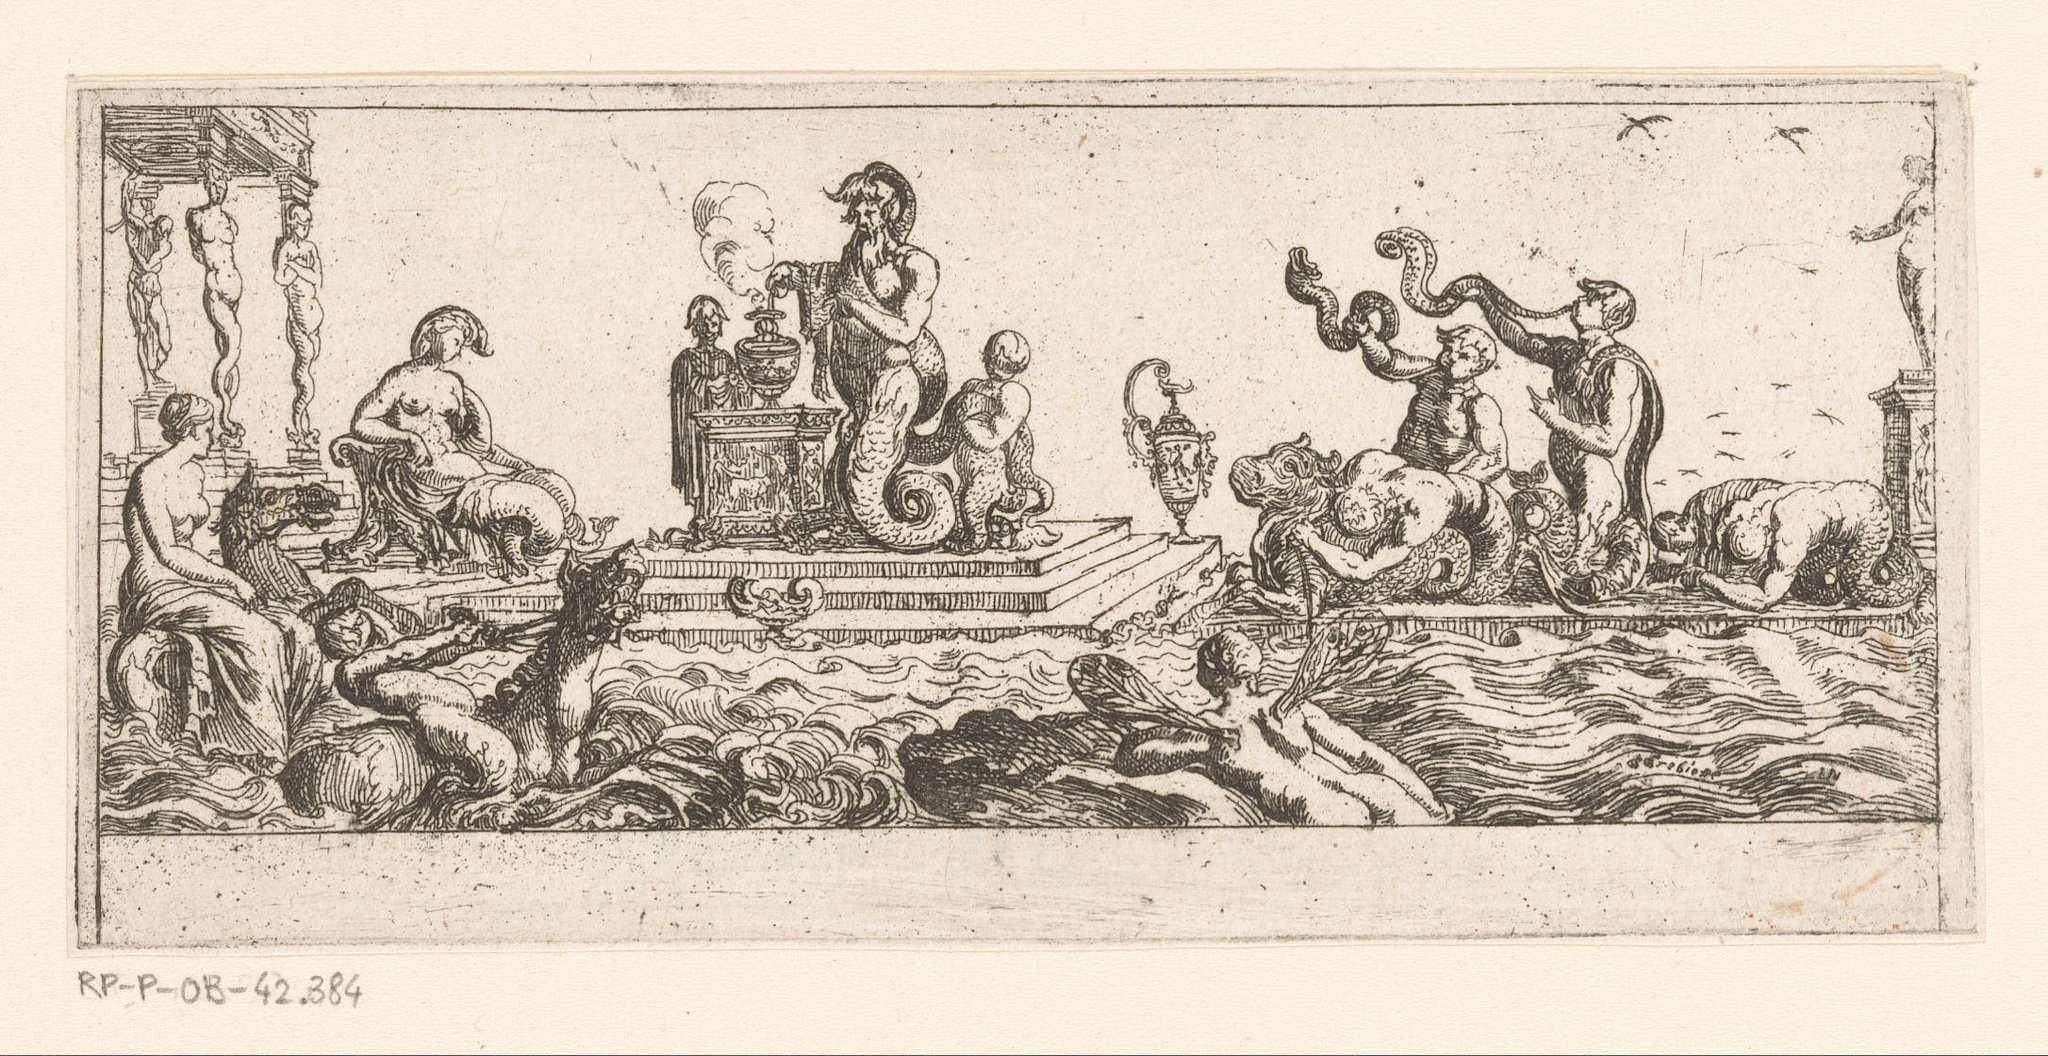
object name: print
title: Offerceremonie met zeegoden, nereïden en tritons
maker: pierre brebiette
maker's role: draughtsman, print maker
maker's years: 1598-1650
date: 1608-1650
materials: paper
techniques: etching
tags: triton(s), nereids, daughters of nereus; sea-nymphs, gods of the waters: the older dynasty (first series): offspring of pontus and the monsters of the sea, sacrifice ~ non-christian religions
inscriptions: collector's mark: Lugt 240